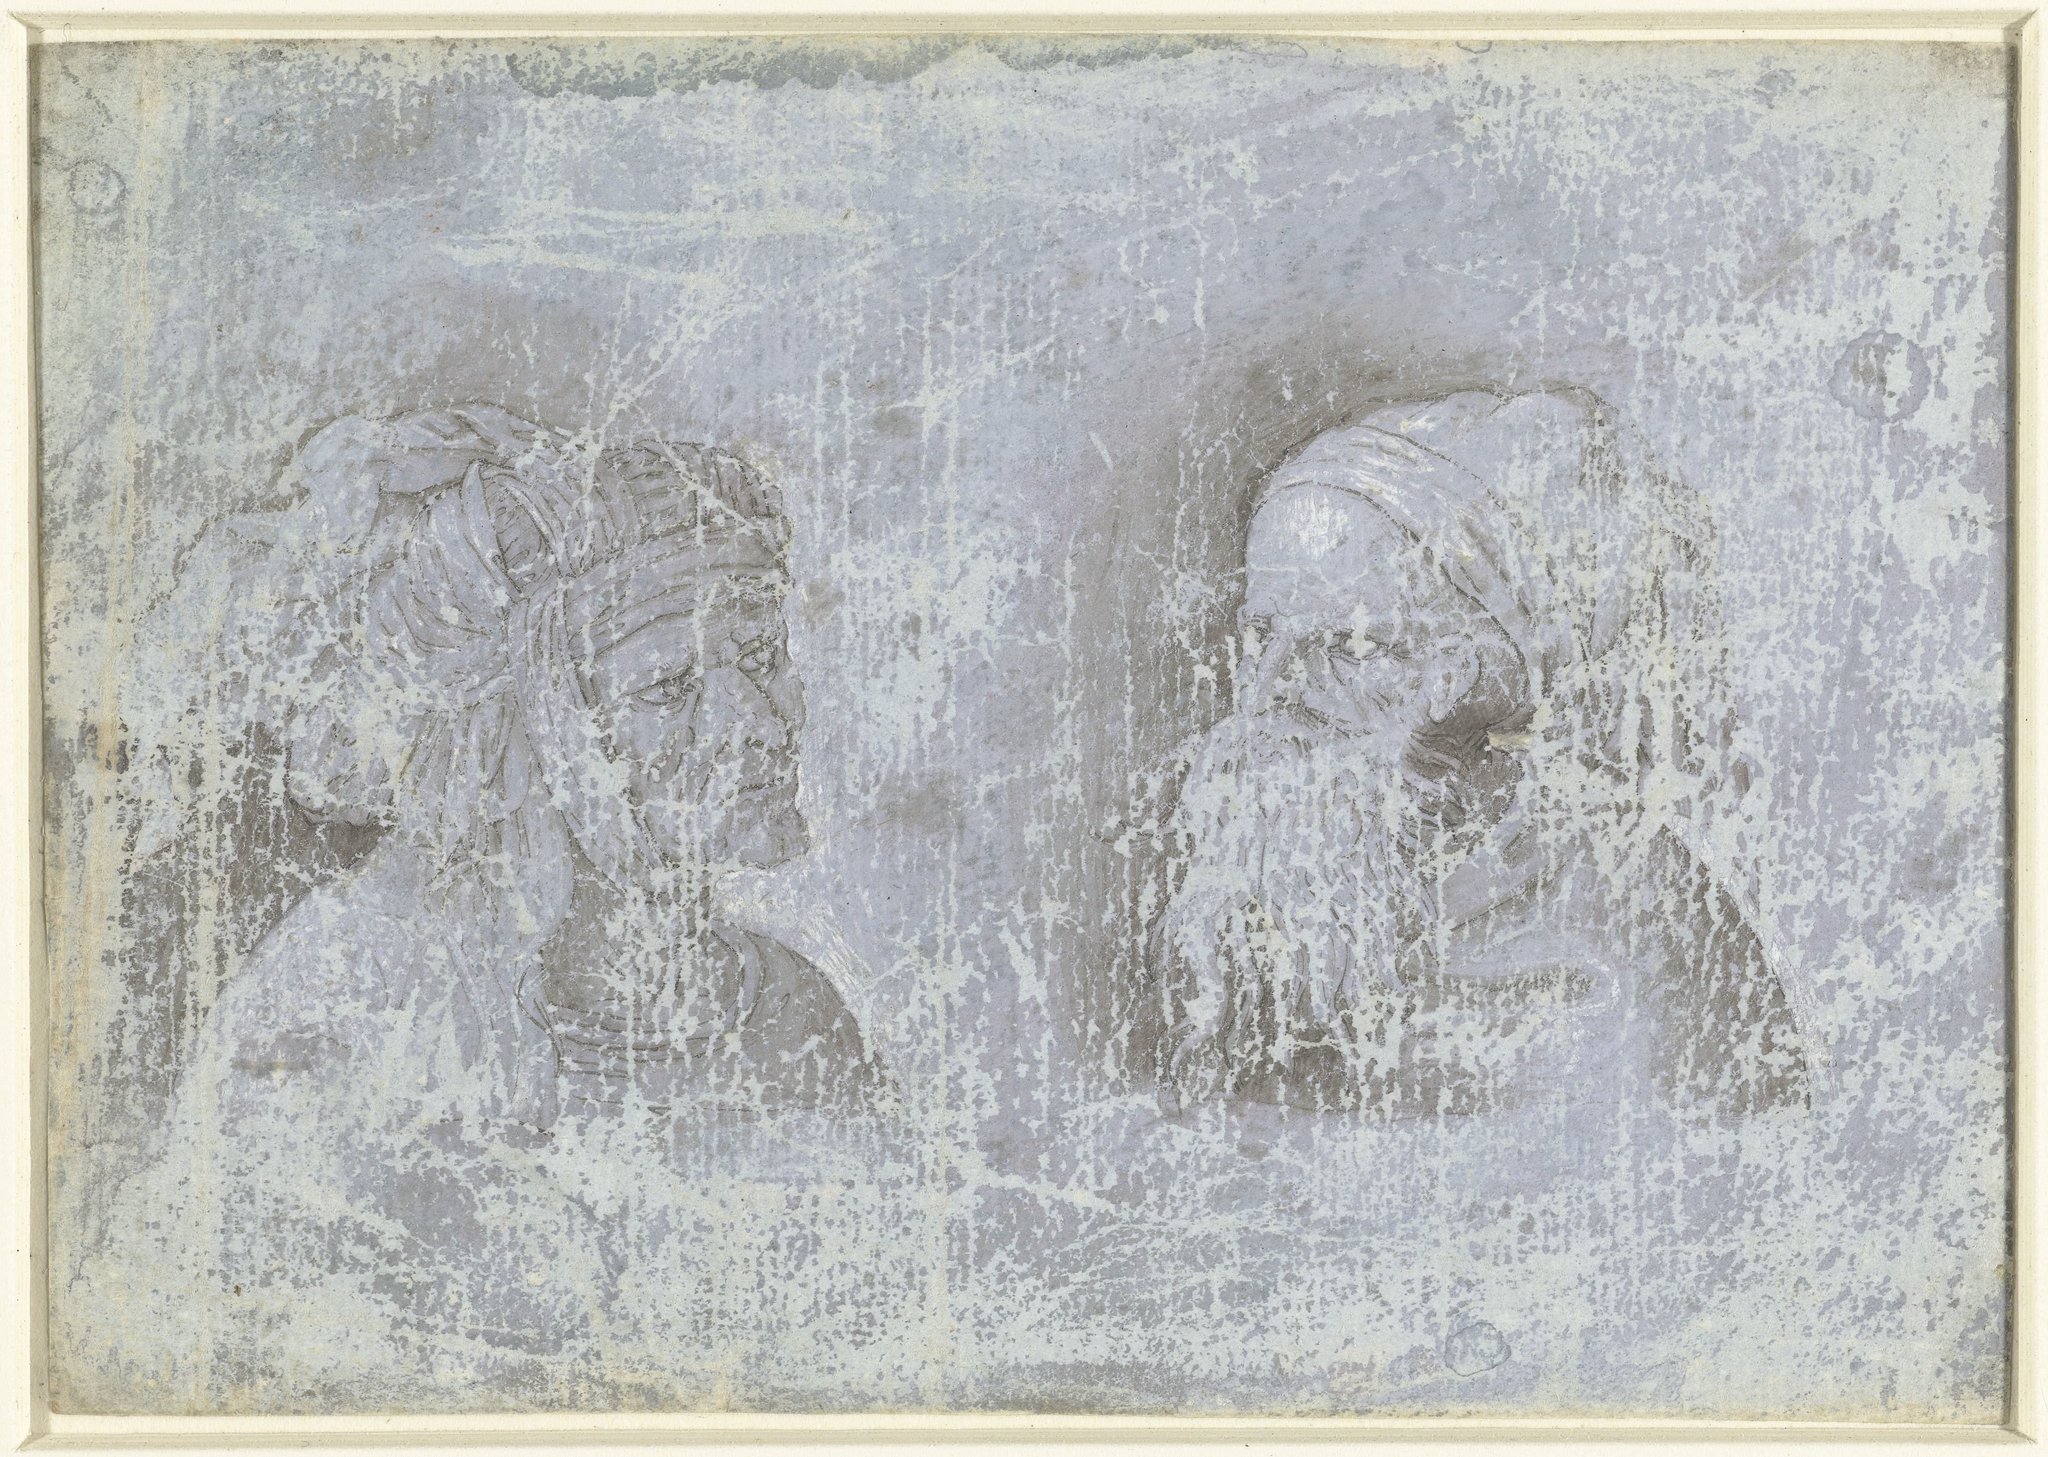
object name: drawing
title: Hoofden van mannen met hoofddeksels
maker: jacopo ripanda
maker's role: draughtsman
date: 1500-1525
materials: ink, paper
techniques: brush, pen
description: Blad uit serie met hoofden van mannen met uitheemse hoofddeksels op blauw en paars geprepareerd papier.